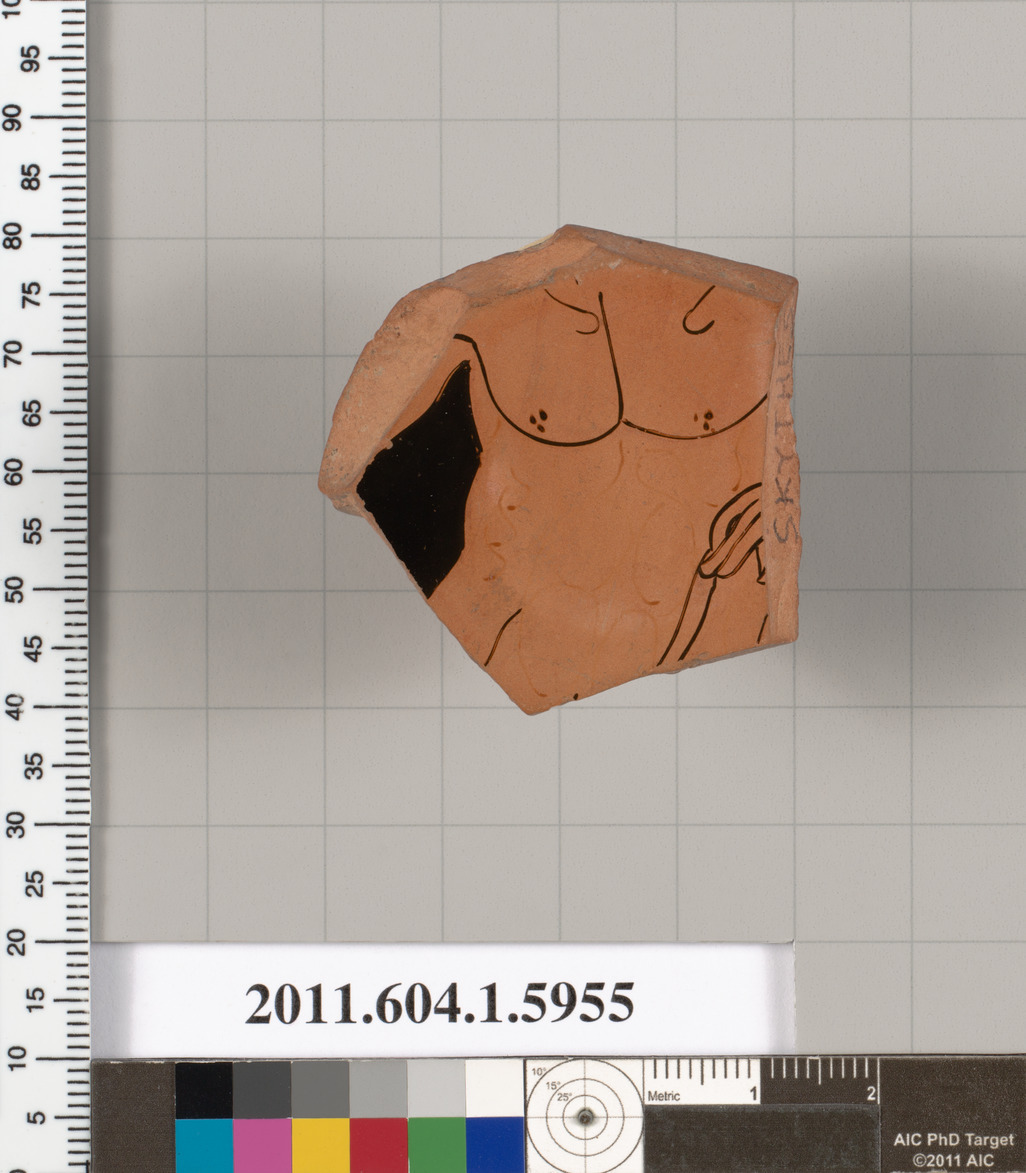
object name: kylix fragment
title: Terracotta fragment of a kylix (drinking cup)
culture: greek, attic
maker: skythes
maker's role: artist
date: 433-567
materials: terracotta